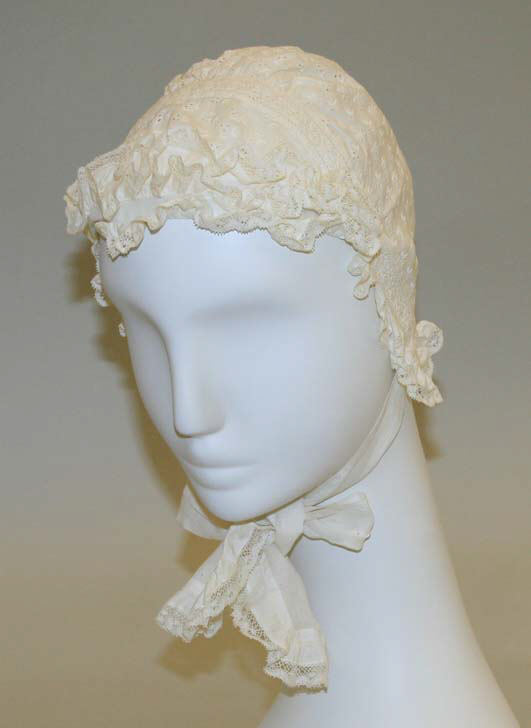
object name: nightcap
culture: american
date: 1801-1900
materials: cotton